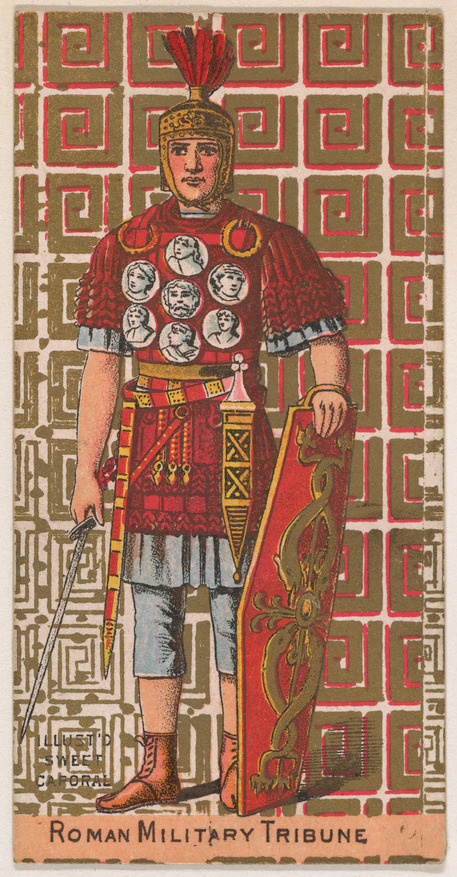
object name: print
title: Roman Military Tribune, from the Military Series (N224) issued by Kinney Tobacco Company to promote Sweet Caporal Cigarettes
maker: kinney brothers tobacco company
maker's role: publisher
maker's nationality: american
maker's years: 1869-2011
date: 1888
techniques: color lithograph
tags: soldiers,men